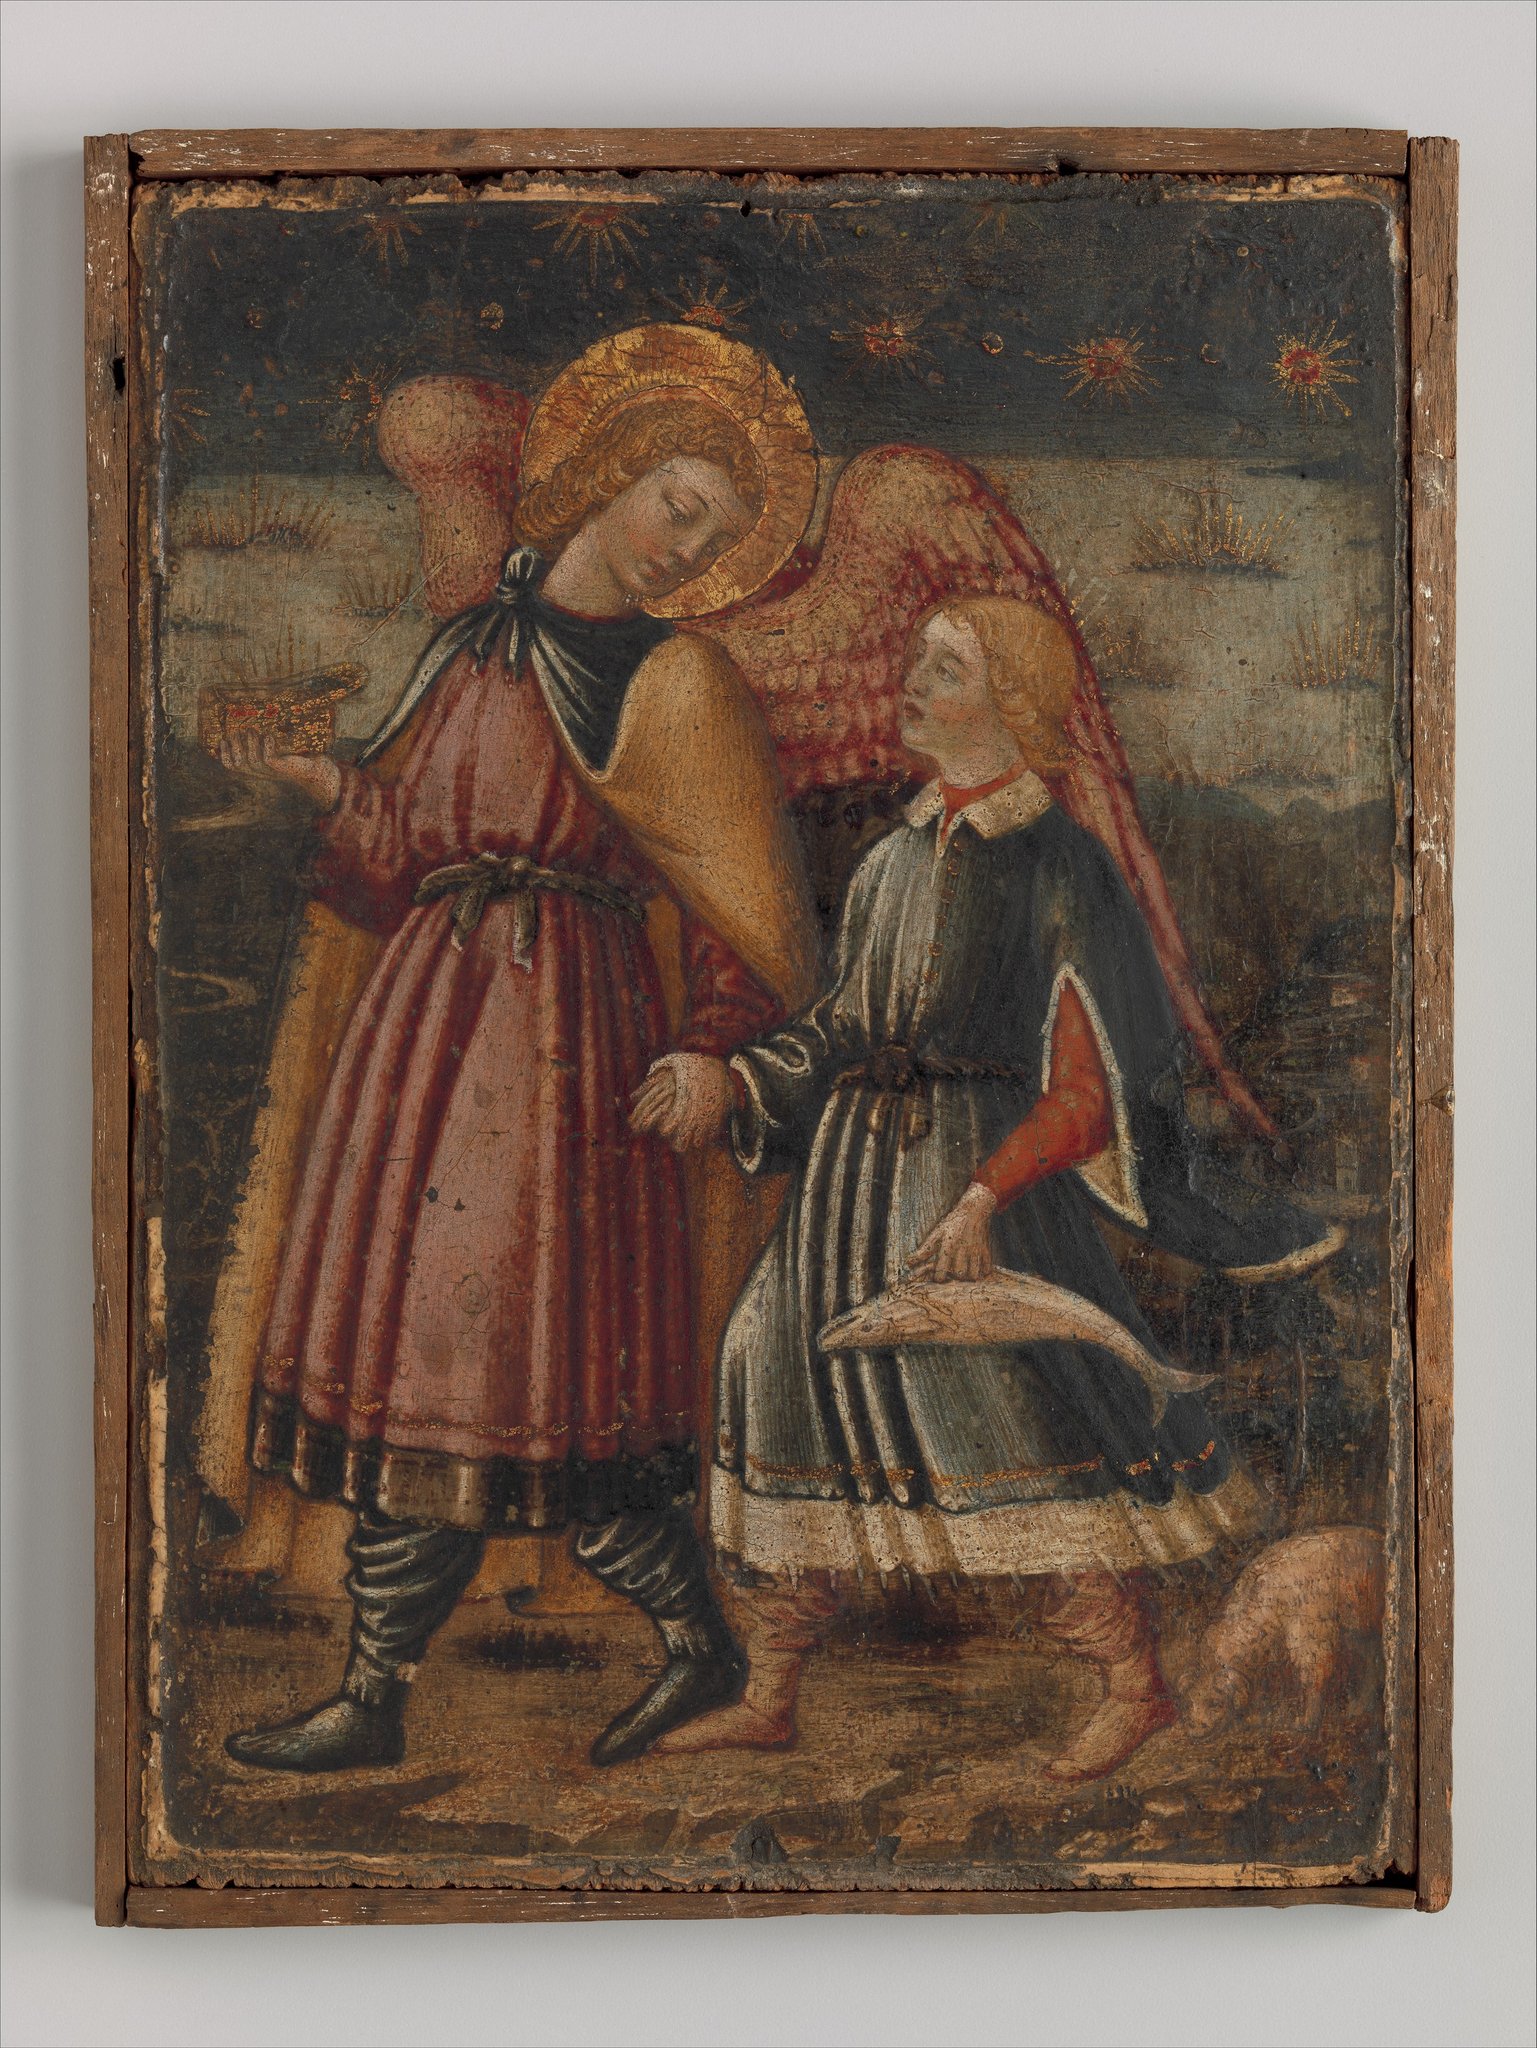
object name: painting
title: The Archangel Raphael and Tobias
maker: neri di bicci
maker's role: artist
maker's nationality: italian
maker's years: 1419-1491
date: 1457-1463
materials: gold, paint, wood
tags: men,fish,angels